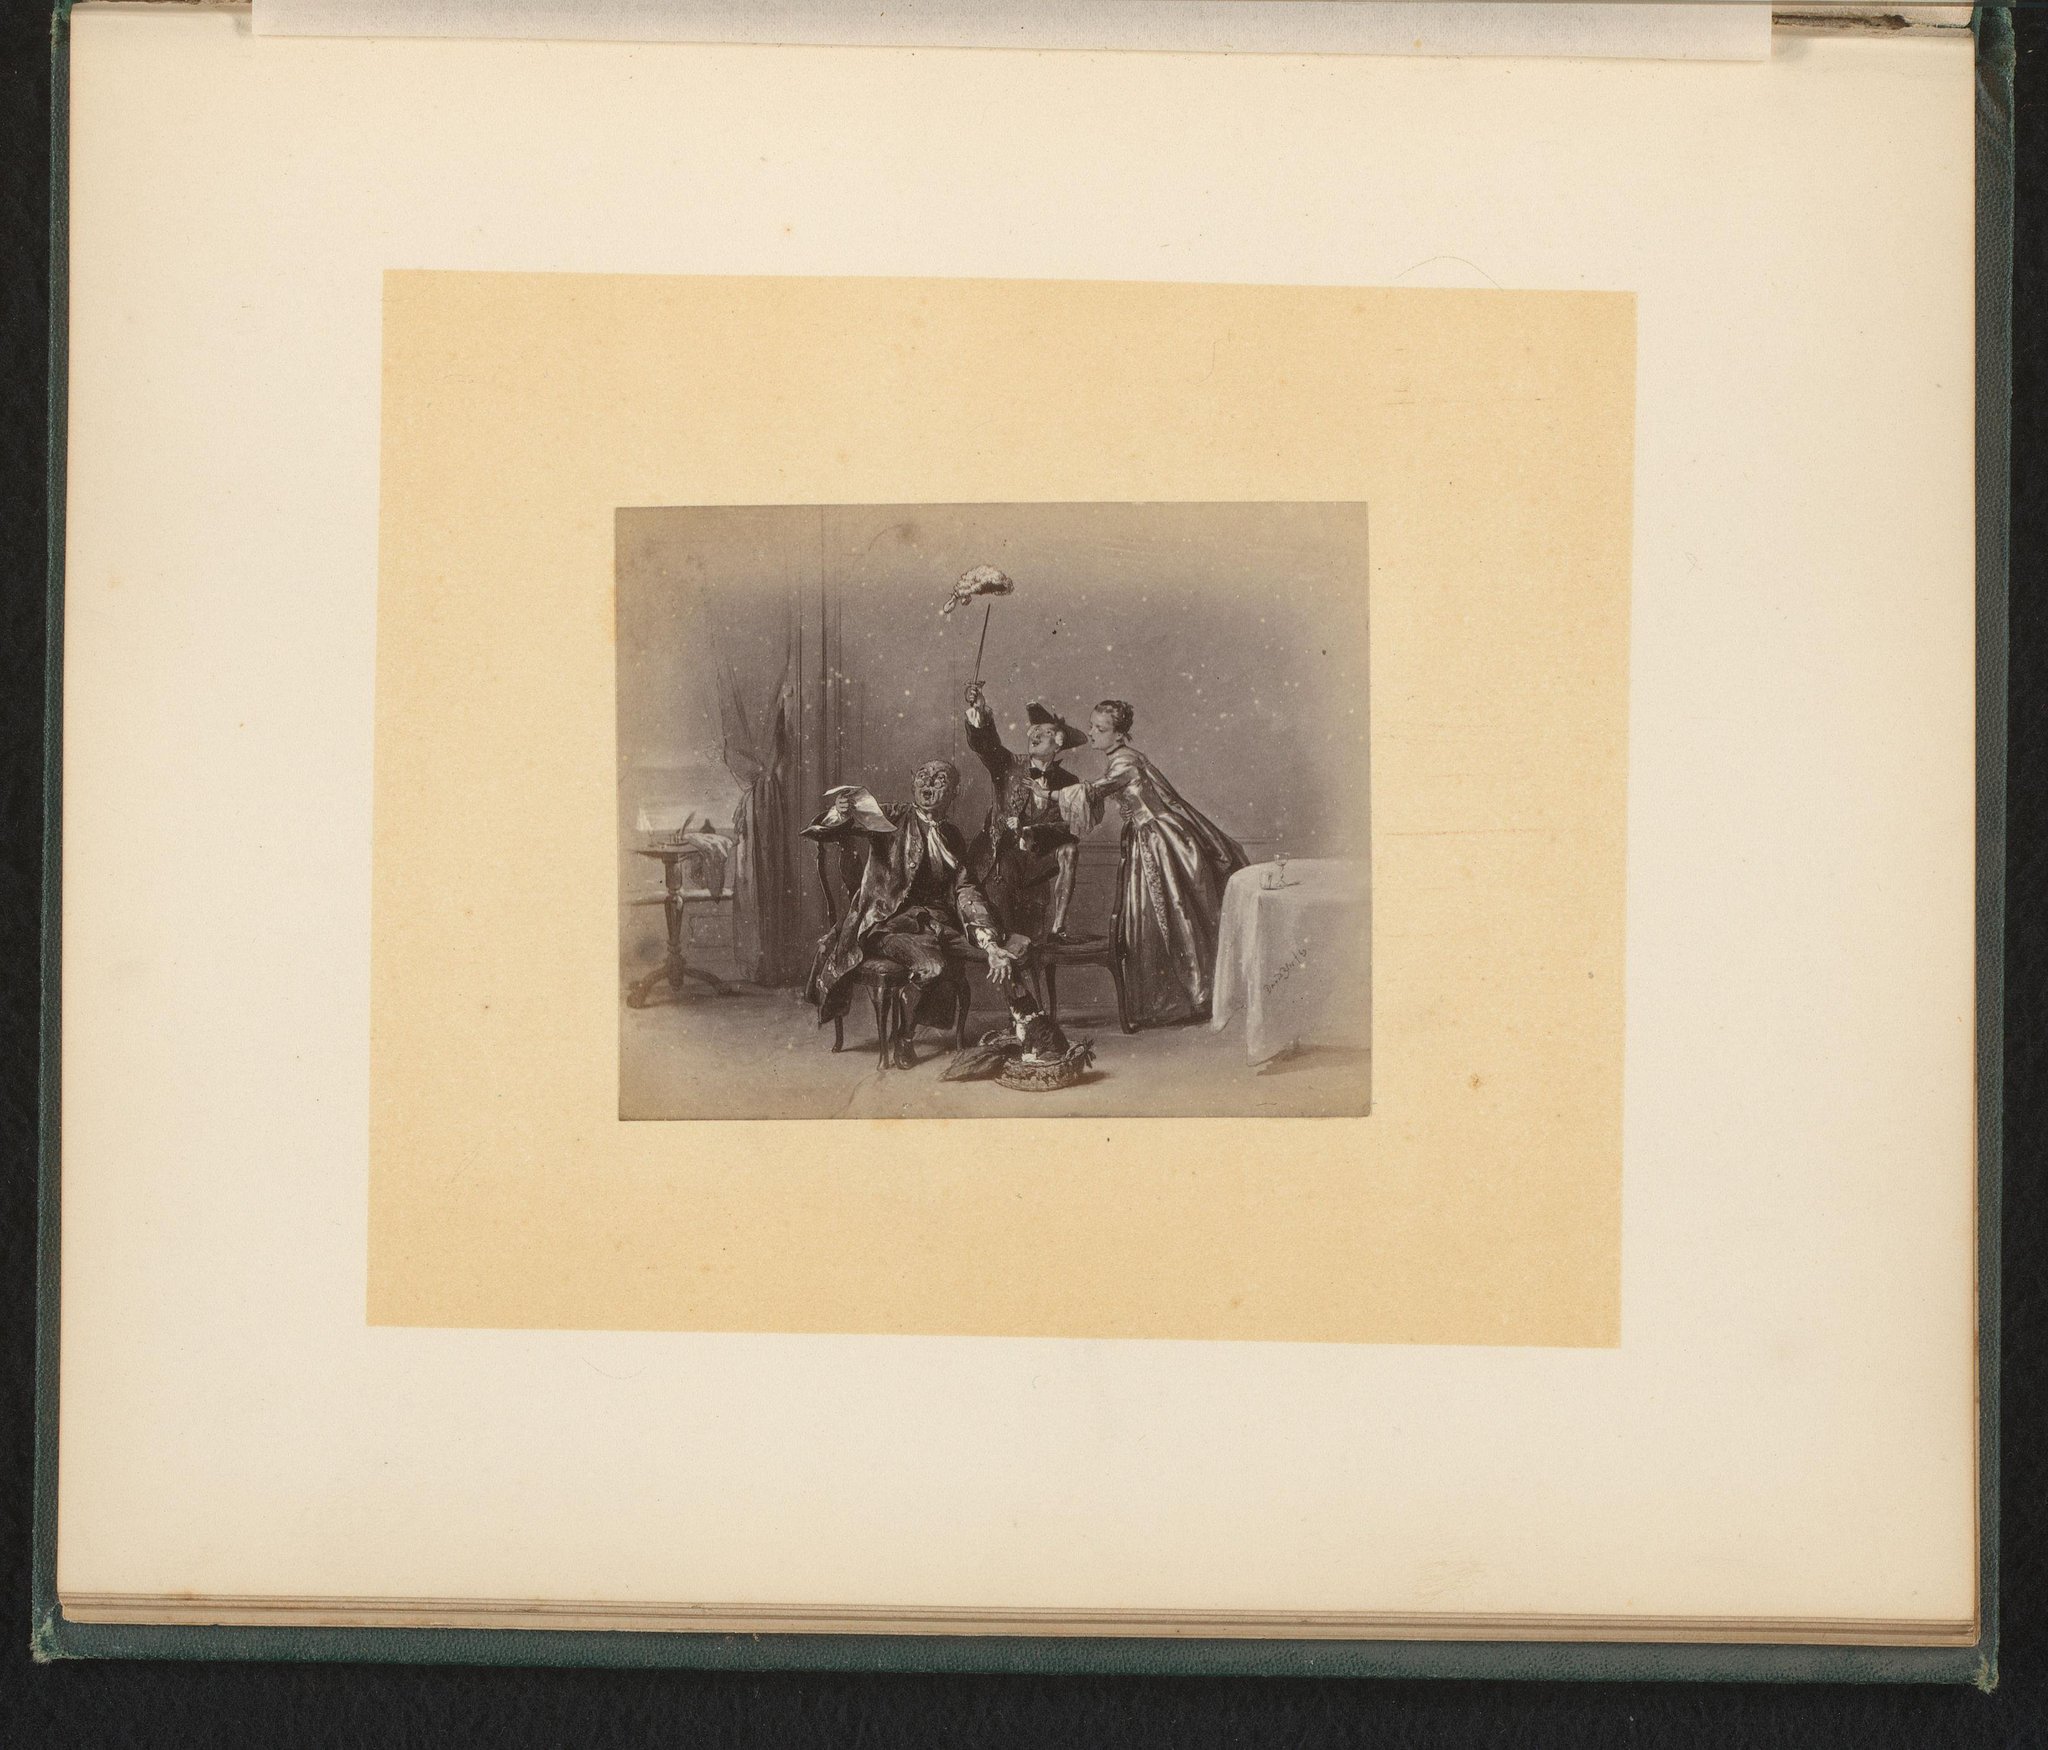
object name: page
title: Fotoreproductie schilderij ter illustratie van Van Lenneps Ferdinand Huyck door David Bles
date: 1870-1880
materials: paper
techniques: albumen print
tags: picture, painting